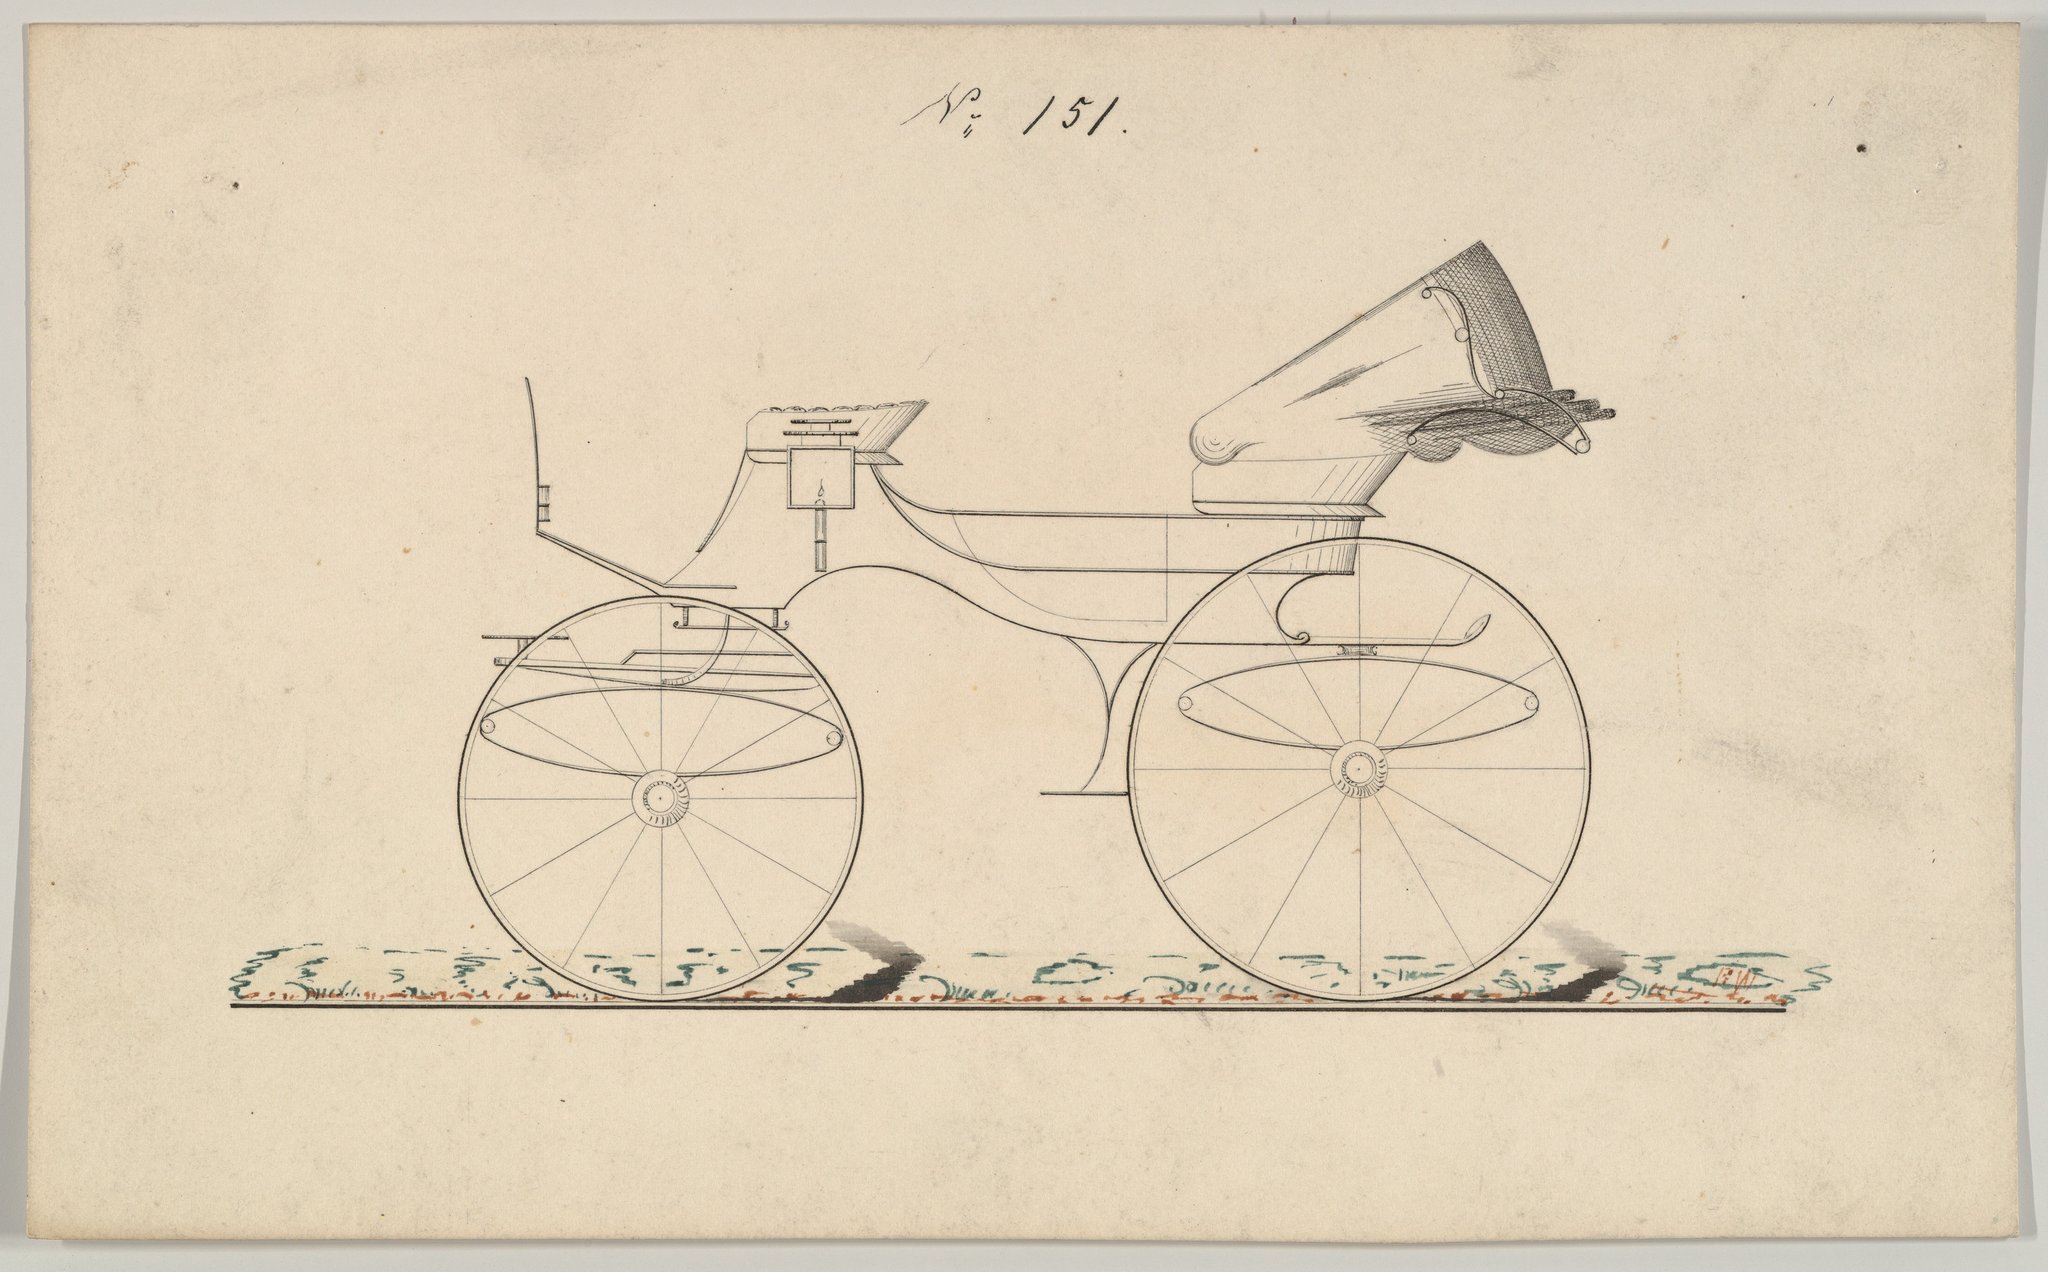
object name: drawing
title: Design for Phaeton/Chariotte, no. 151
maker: brewster & co.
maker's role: manufacturer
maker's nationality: american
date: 1850-1874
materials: ink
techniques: pen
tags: carriages